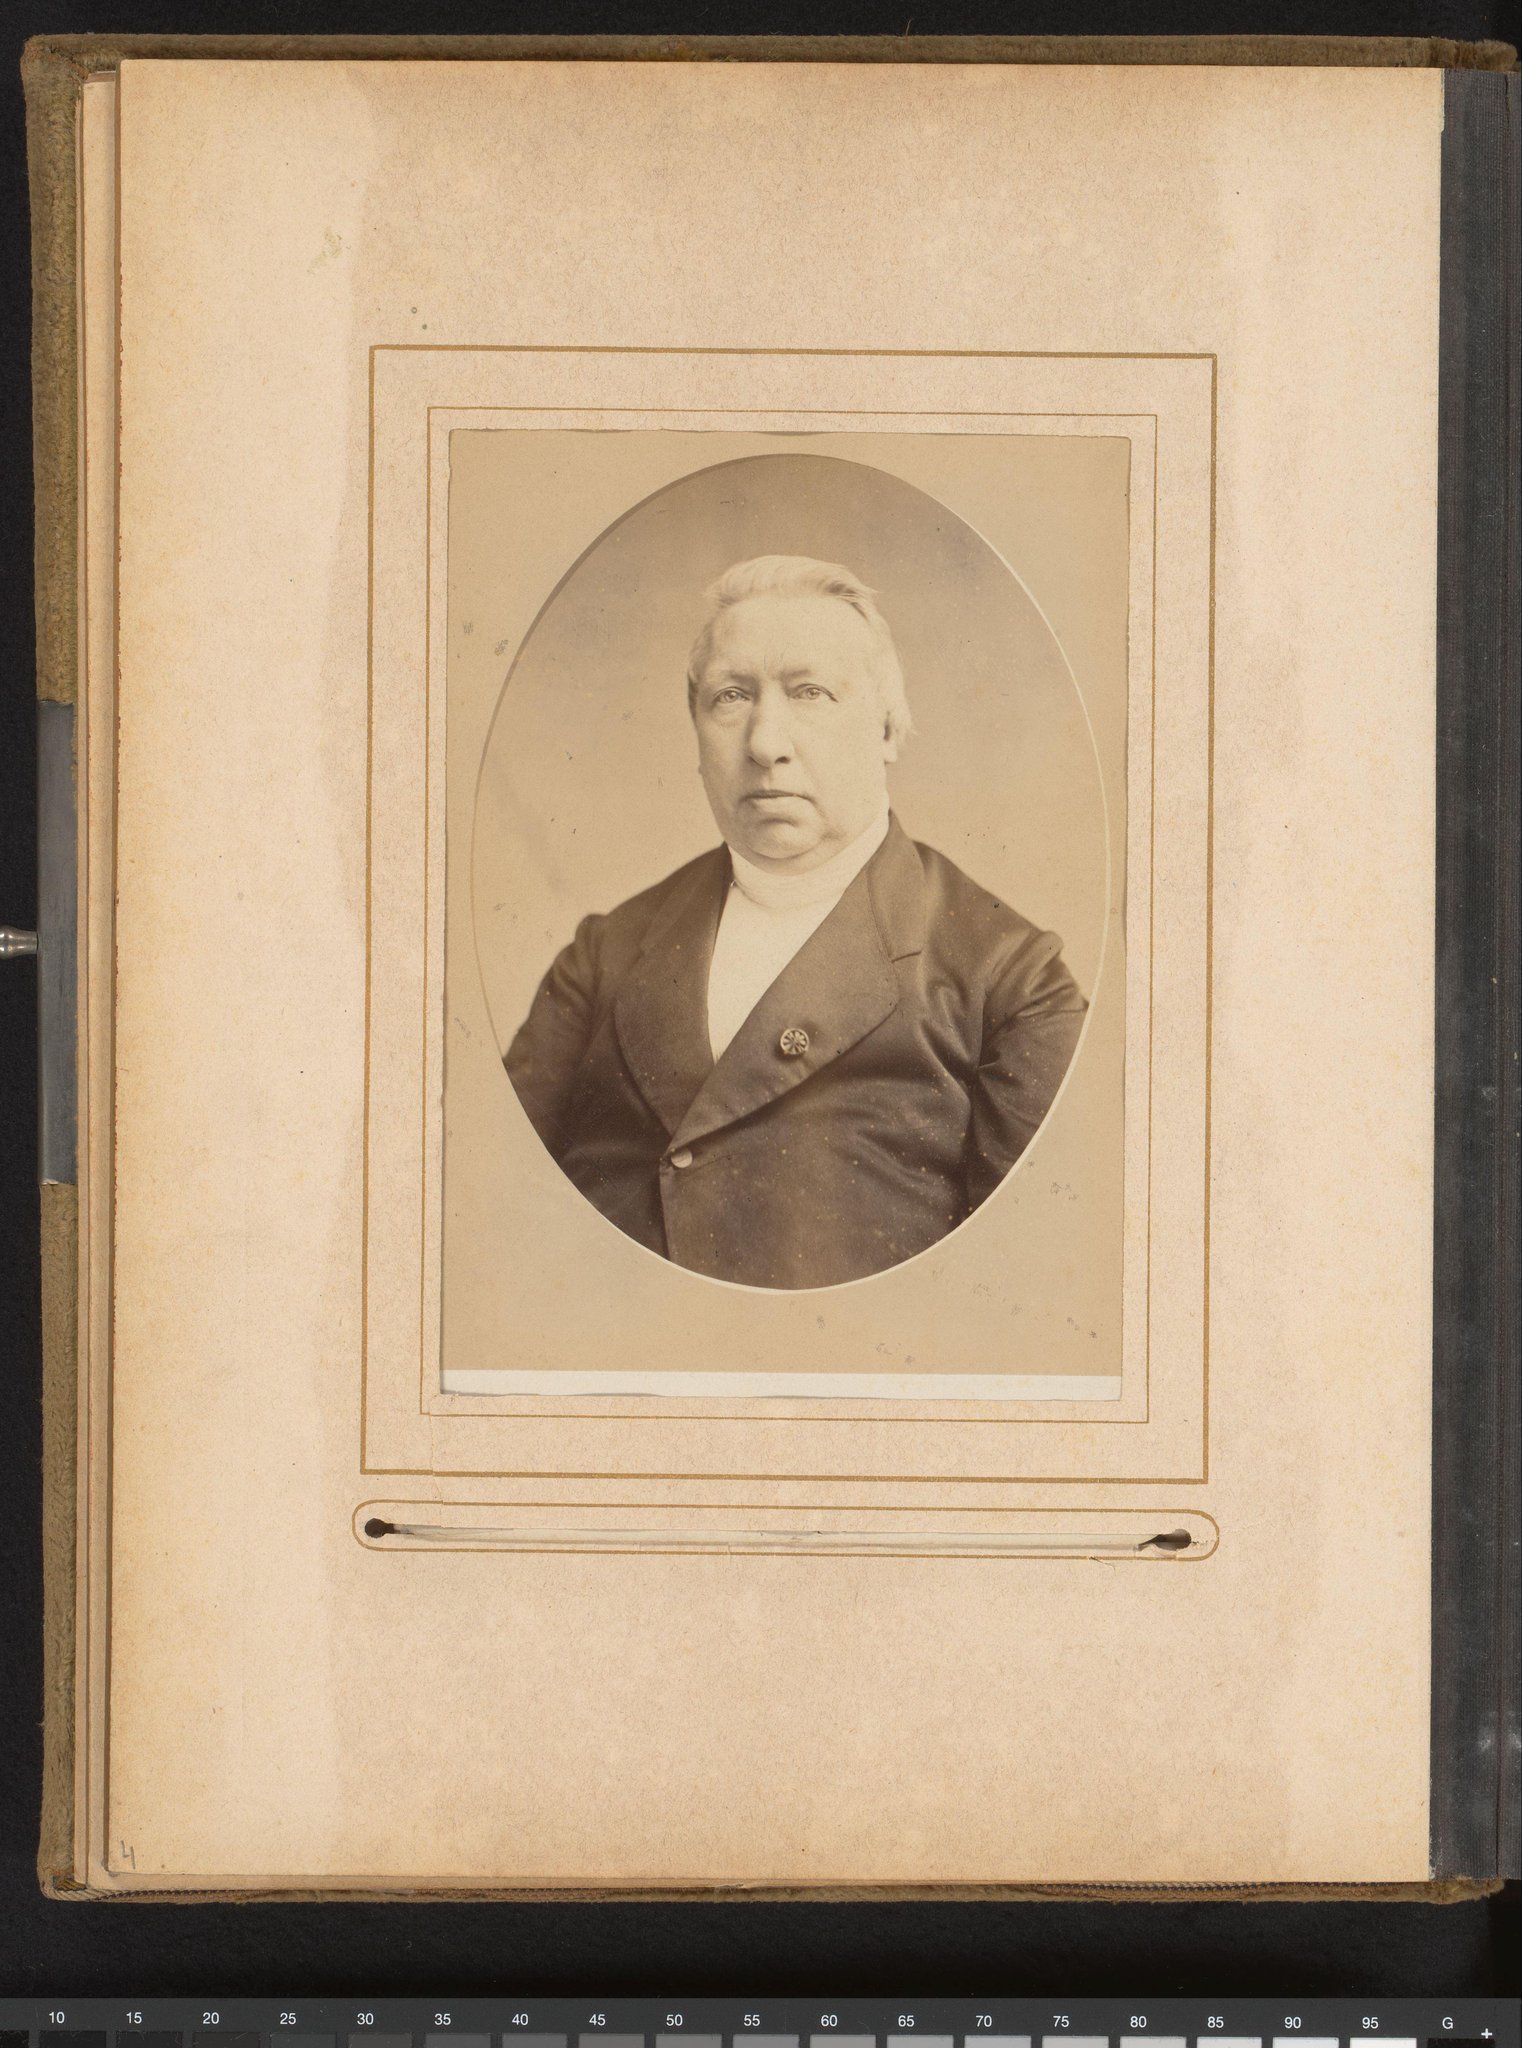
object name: cabinet photograph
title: Portret van een man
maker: jacob hohmann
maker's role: fotograaf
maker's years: 1833-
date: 1863-1892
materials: cardboard, photographic support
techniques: albumen print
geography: the hague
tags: historical persons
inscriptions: inscription: ‘Photogr. Atelier/ van/ J. Hohmann/ Willemstraat No. 59/ 's Gravenhage/ Uitgave van/ H. Hoogh & Comp./ Amsterdam/ Nieuwendyk L76’, inscription: ‘J. Hohmann/ Willemstraat 59/ 's Gravenhage’